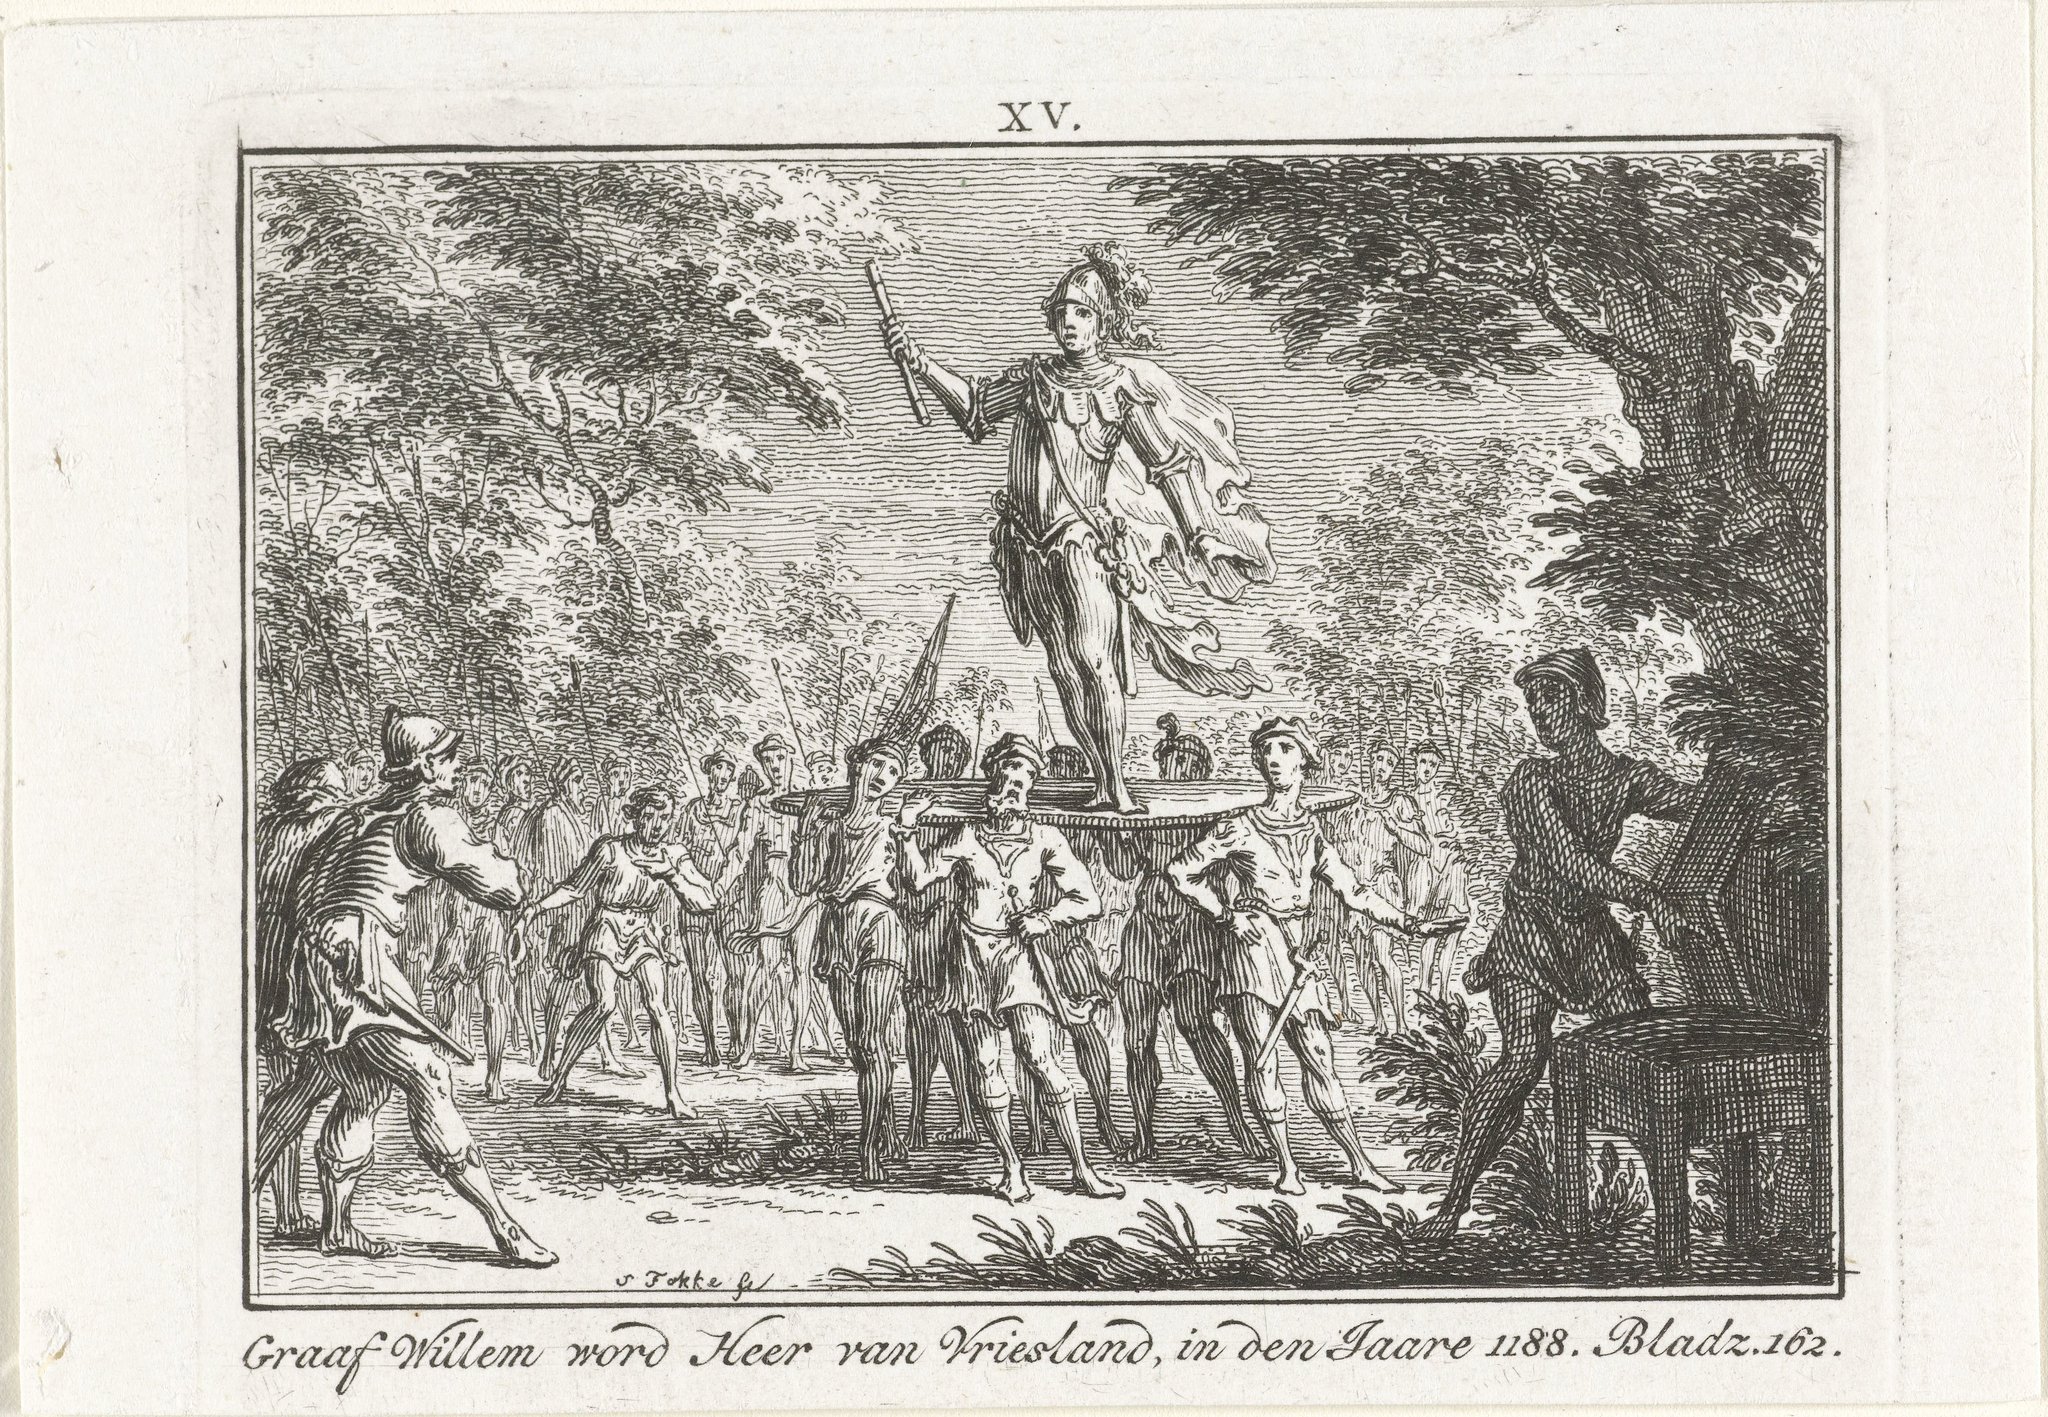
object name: print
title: Illustraties vaderlandse geschiedenis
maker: simon fokke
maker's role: draughtsman, print maker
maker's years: 1712-1784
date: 1784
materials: paper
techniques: etching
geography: amsterdam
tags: new ruler raised on the shield, netherlands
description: Voorstelling uit de vaderlandse geschiedenis. Graaf Willem I is op een schild geheven en wordt gehuldigd als heer van Friesland (volgens de prent in het jaar 1188). Voorstelling bovenaan genummerd: XV.